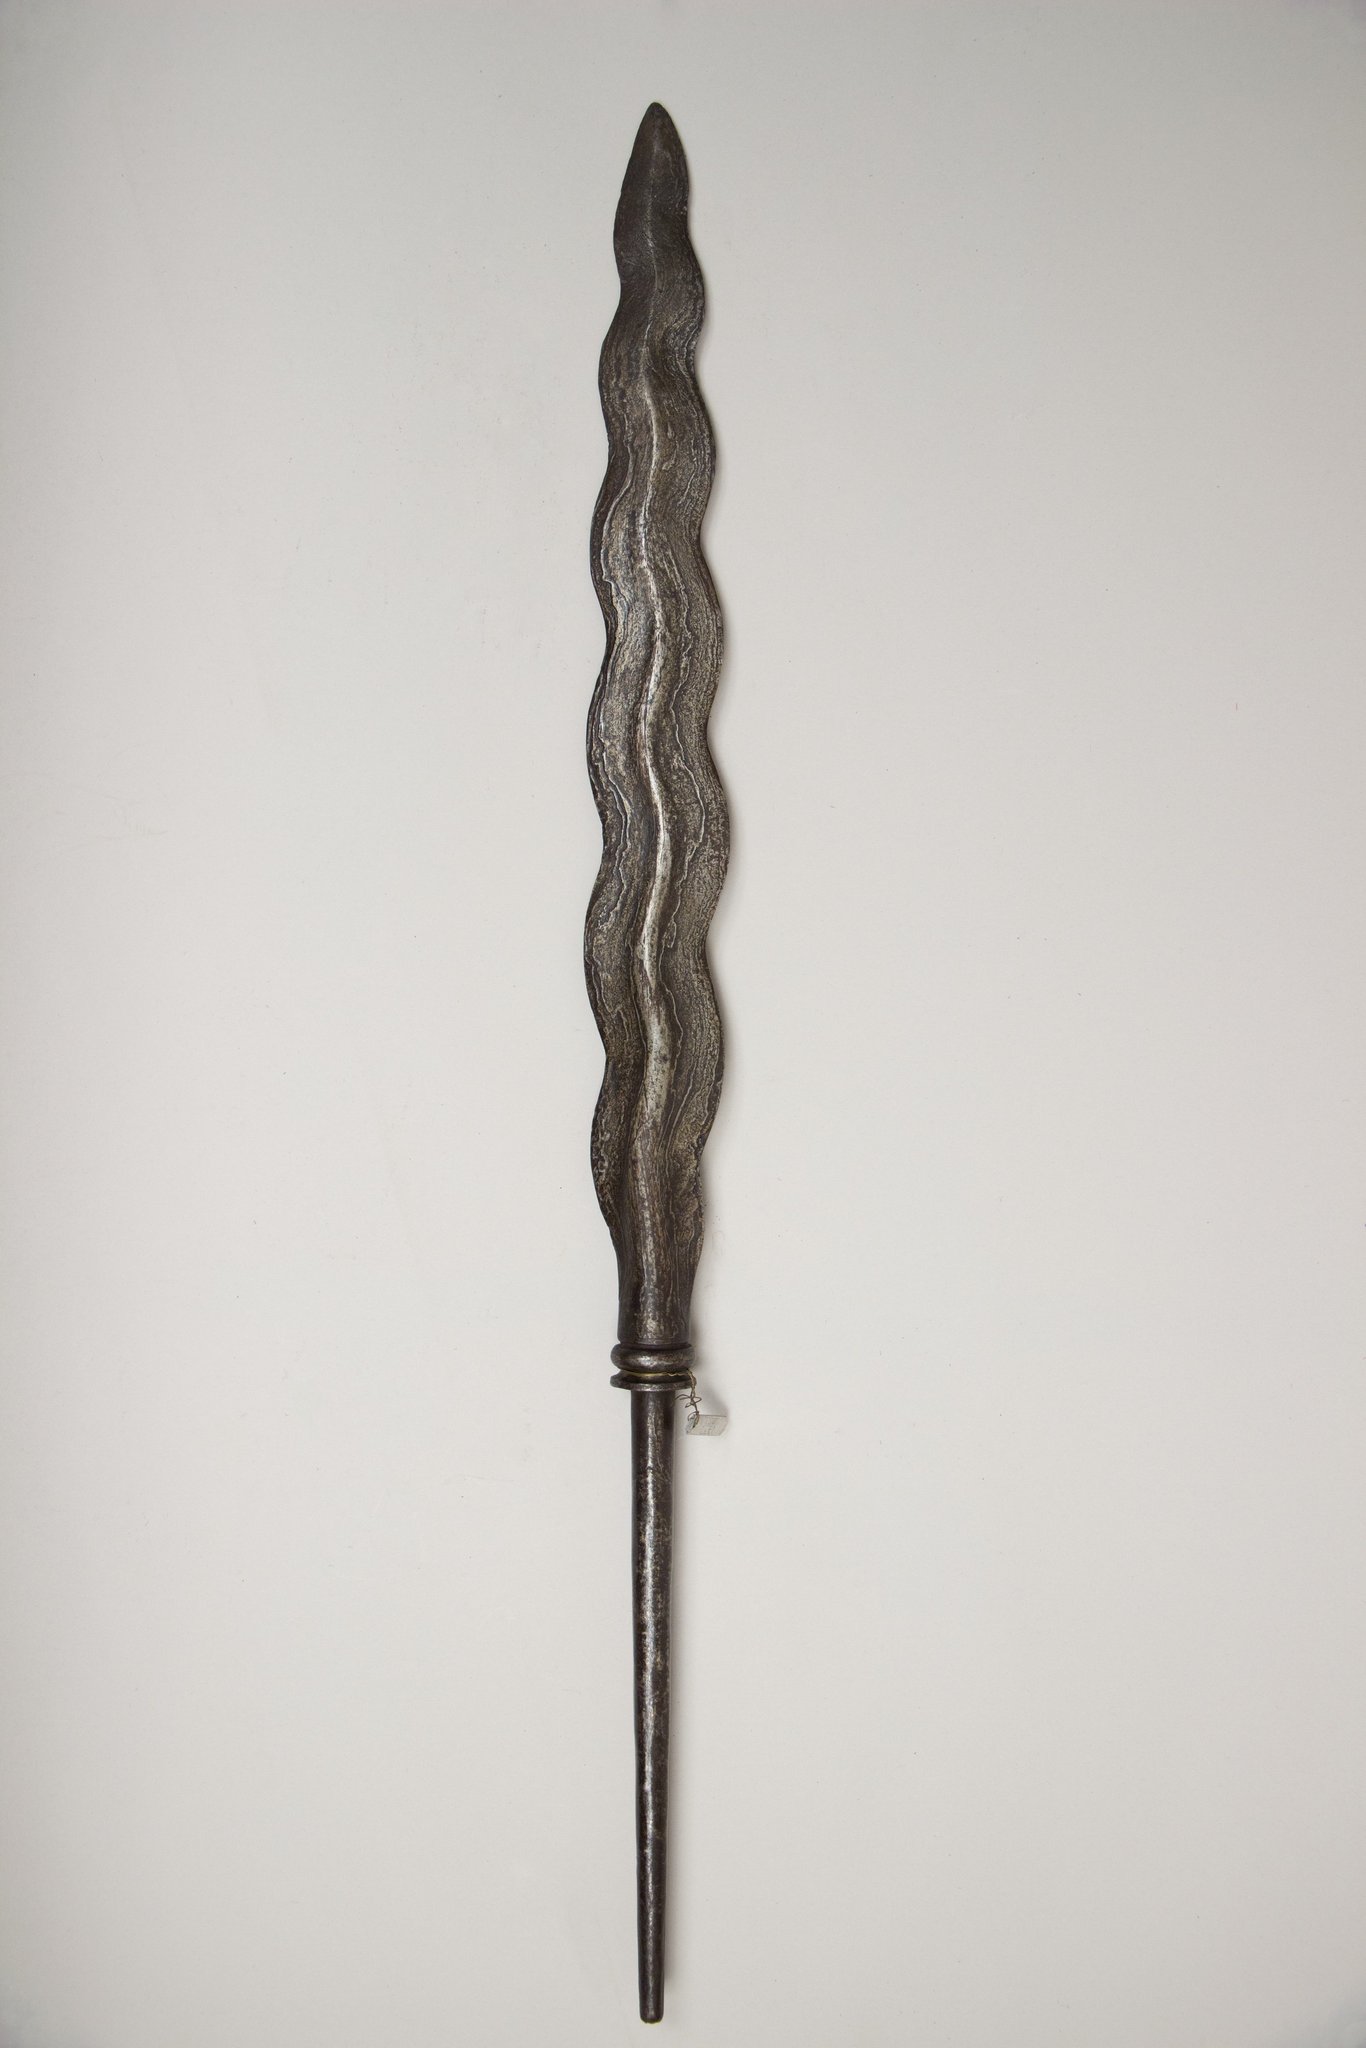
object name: spearhead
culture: javanese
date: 1501-1900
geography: indonesia